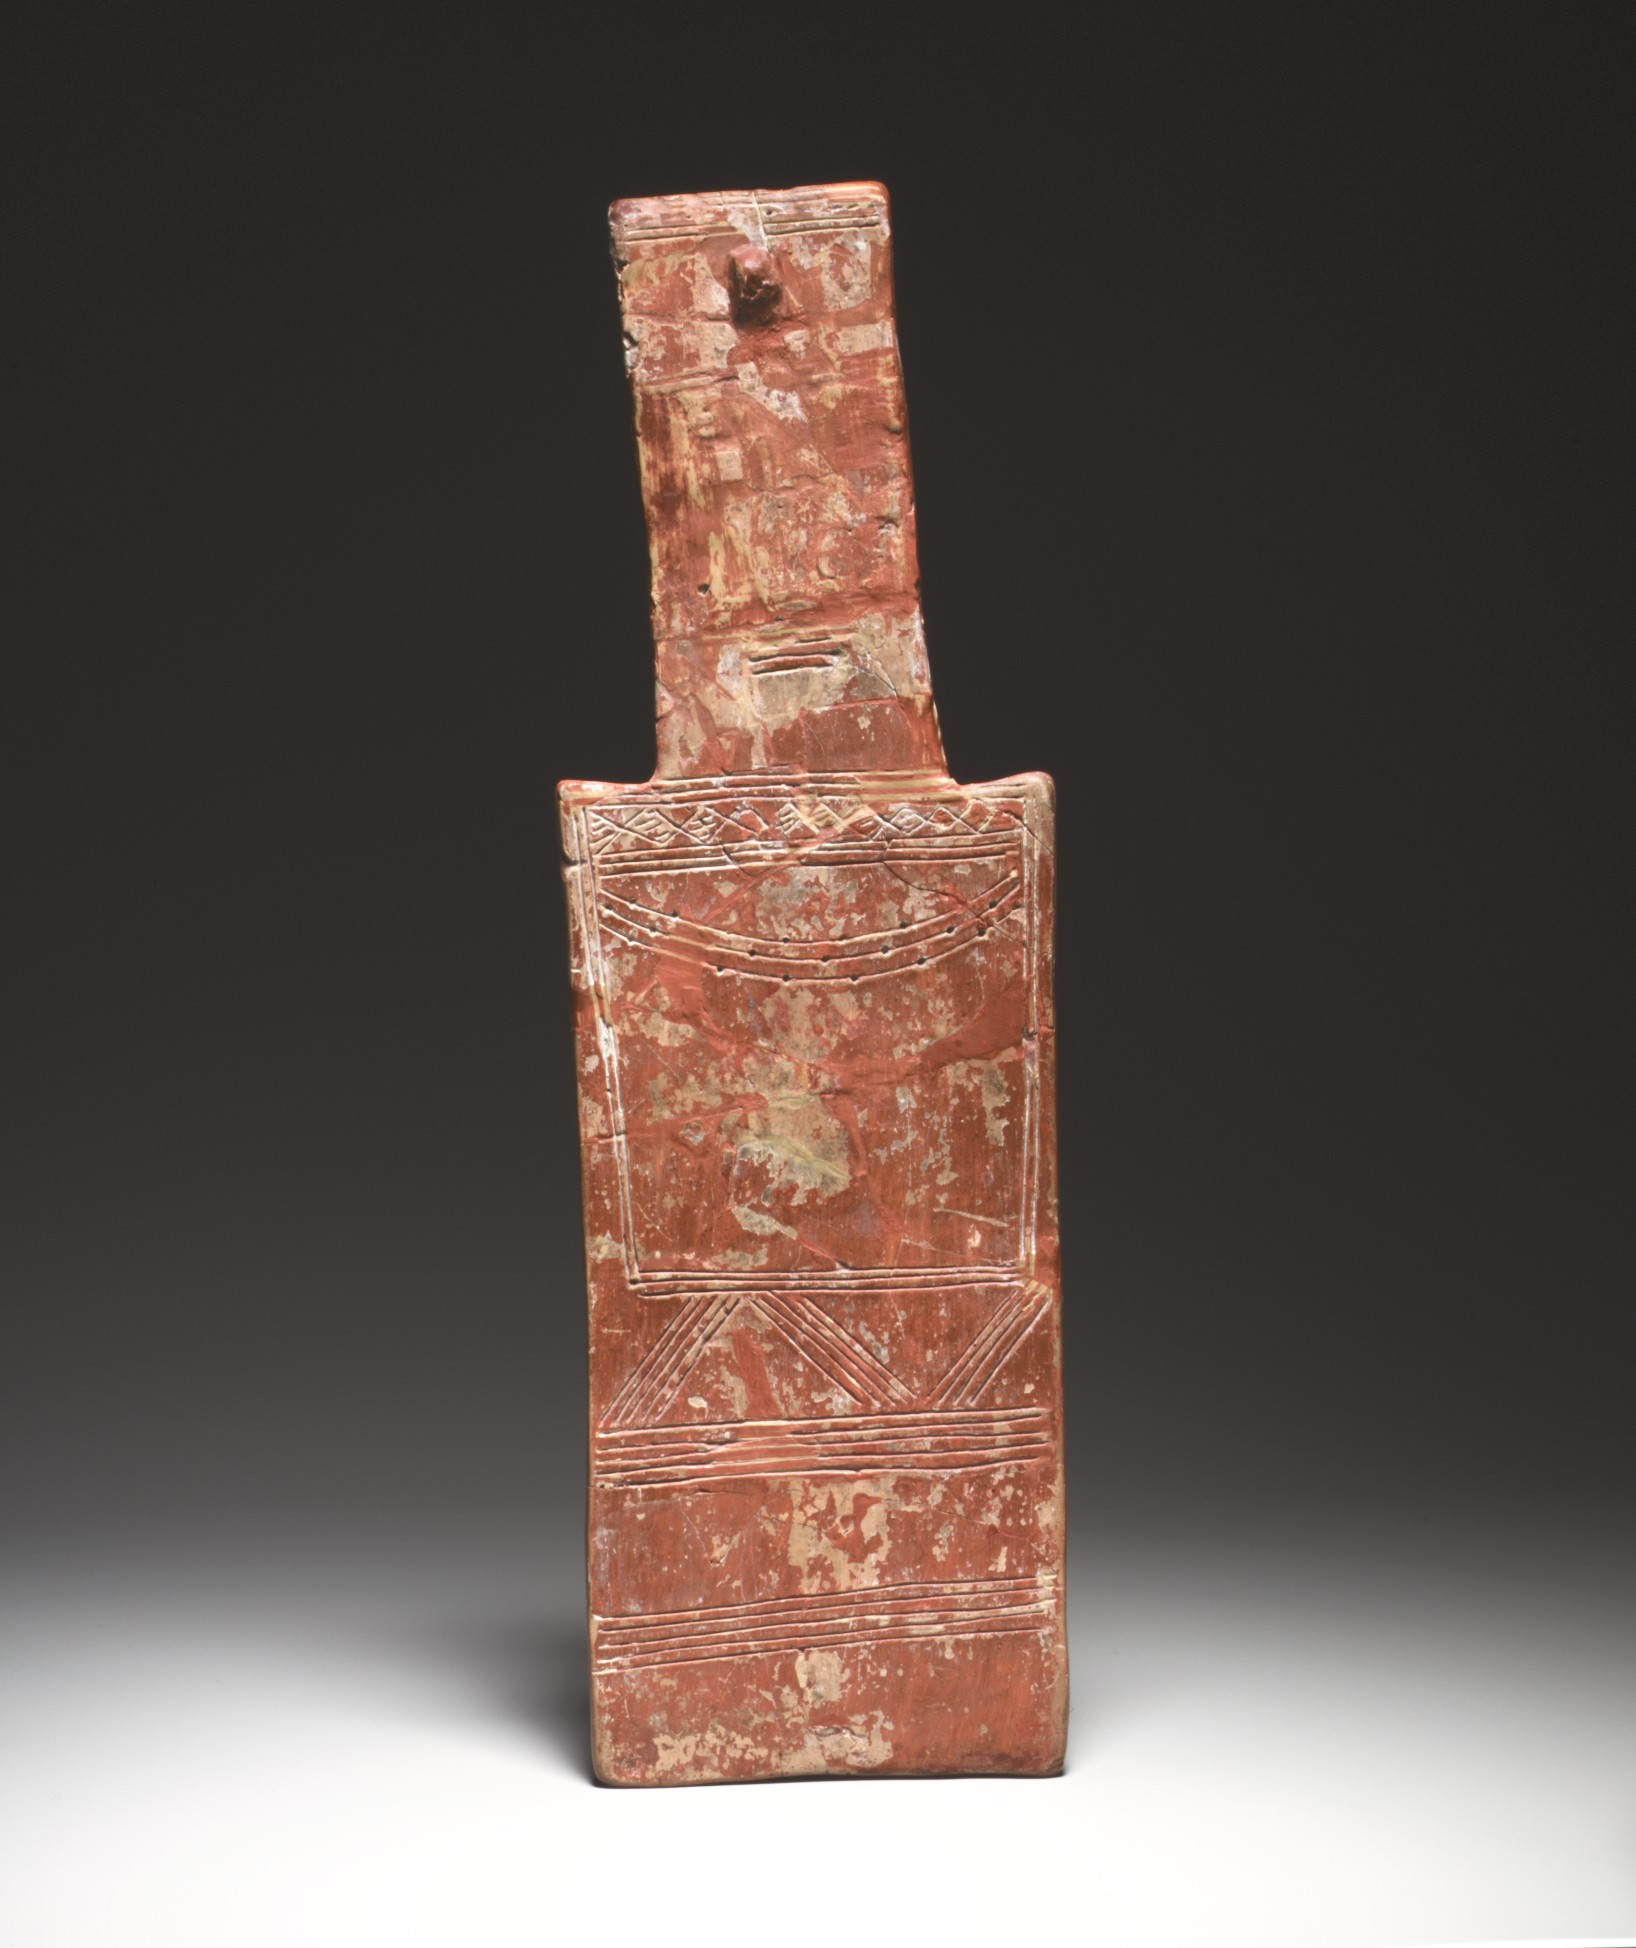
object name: figurine of a woman, plank shaped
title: Terracotta plank-shaped figurine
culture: cypriot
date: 2000-1800 BCE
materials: terracotta